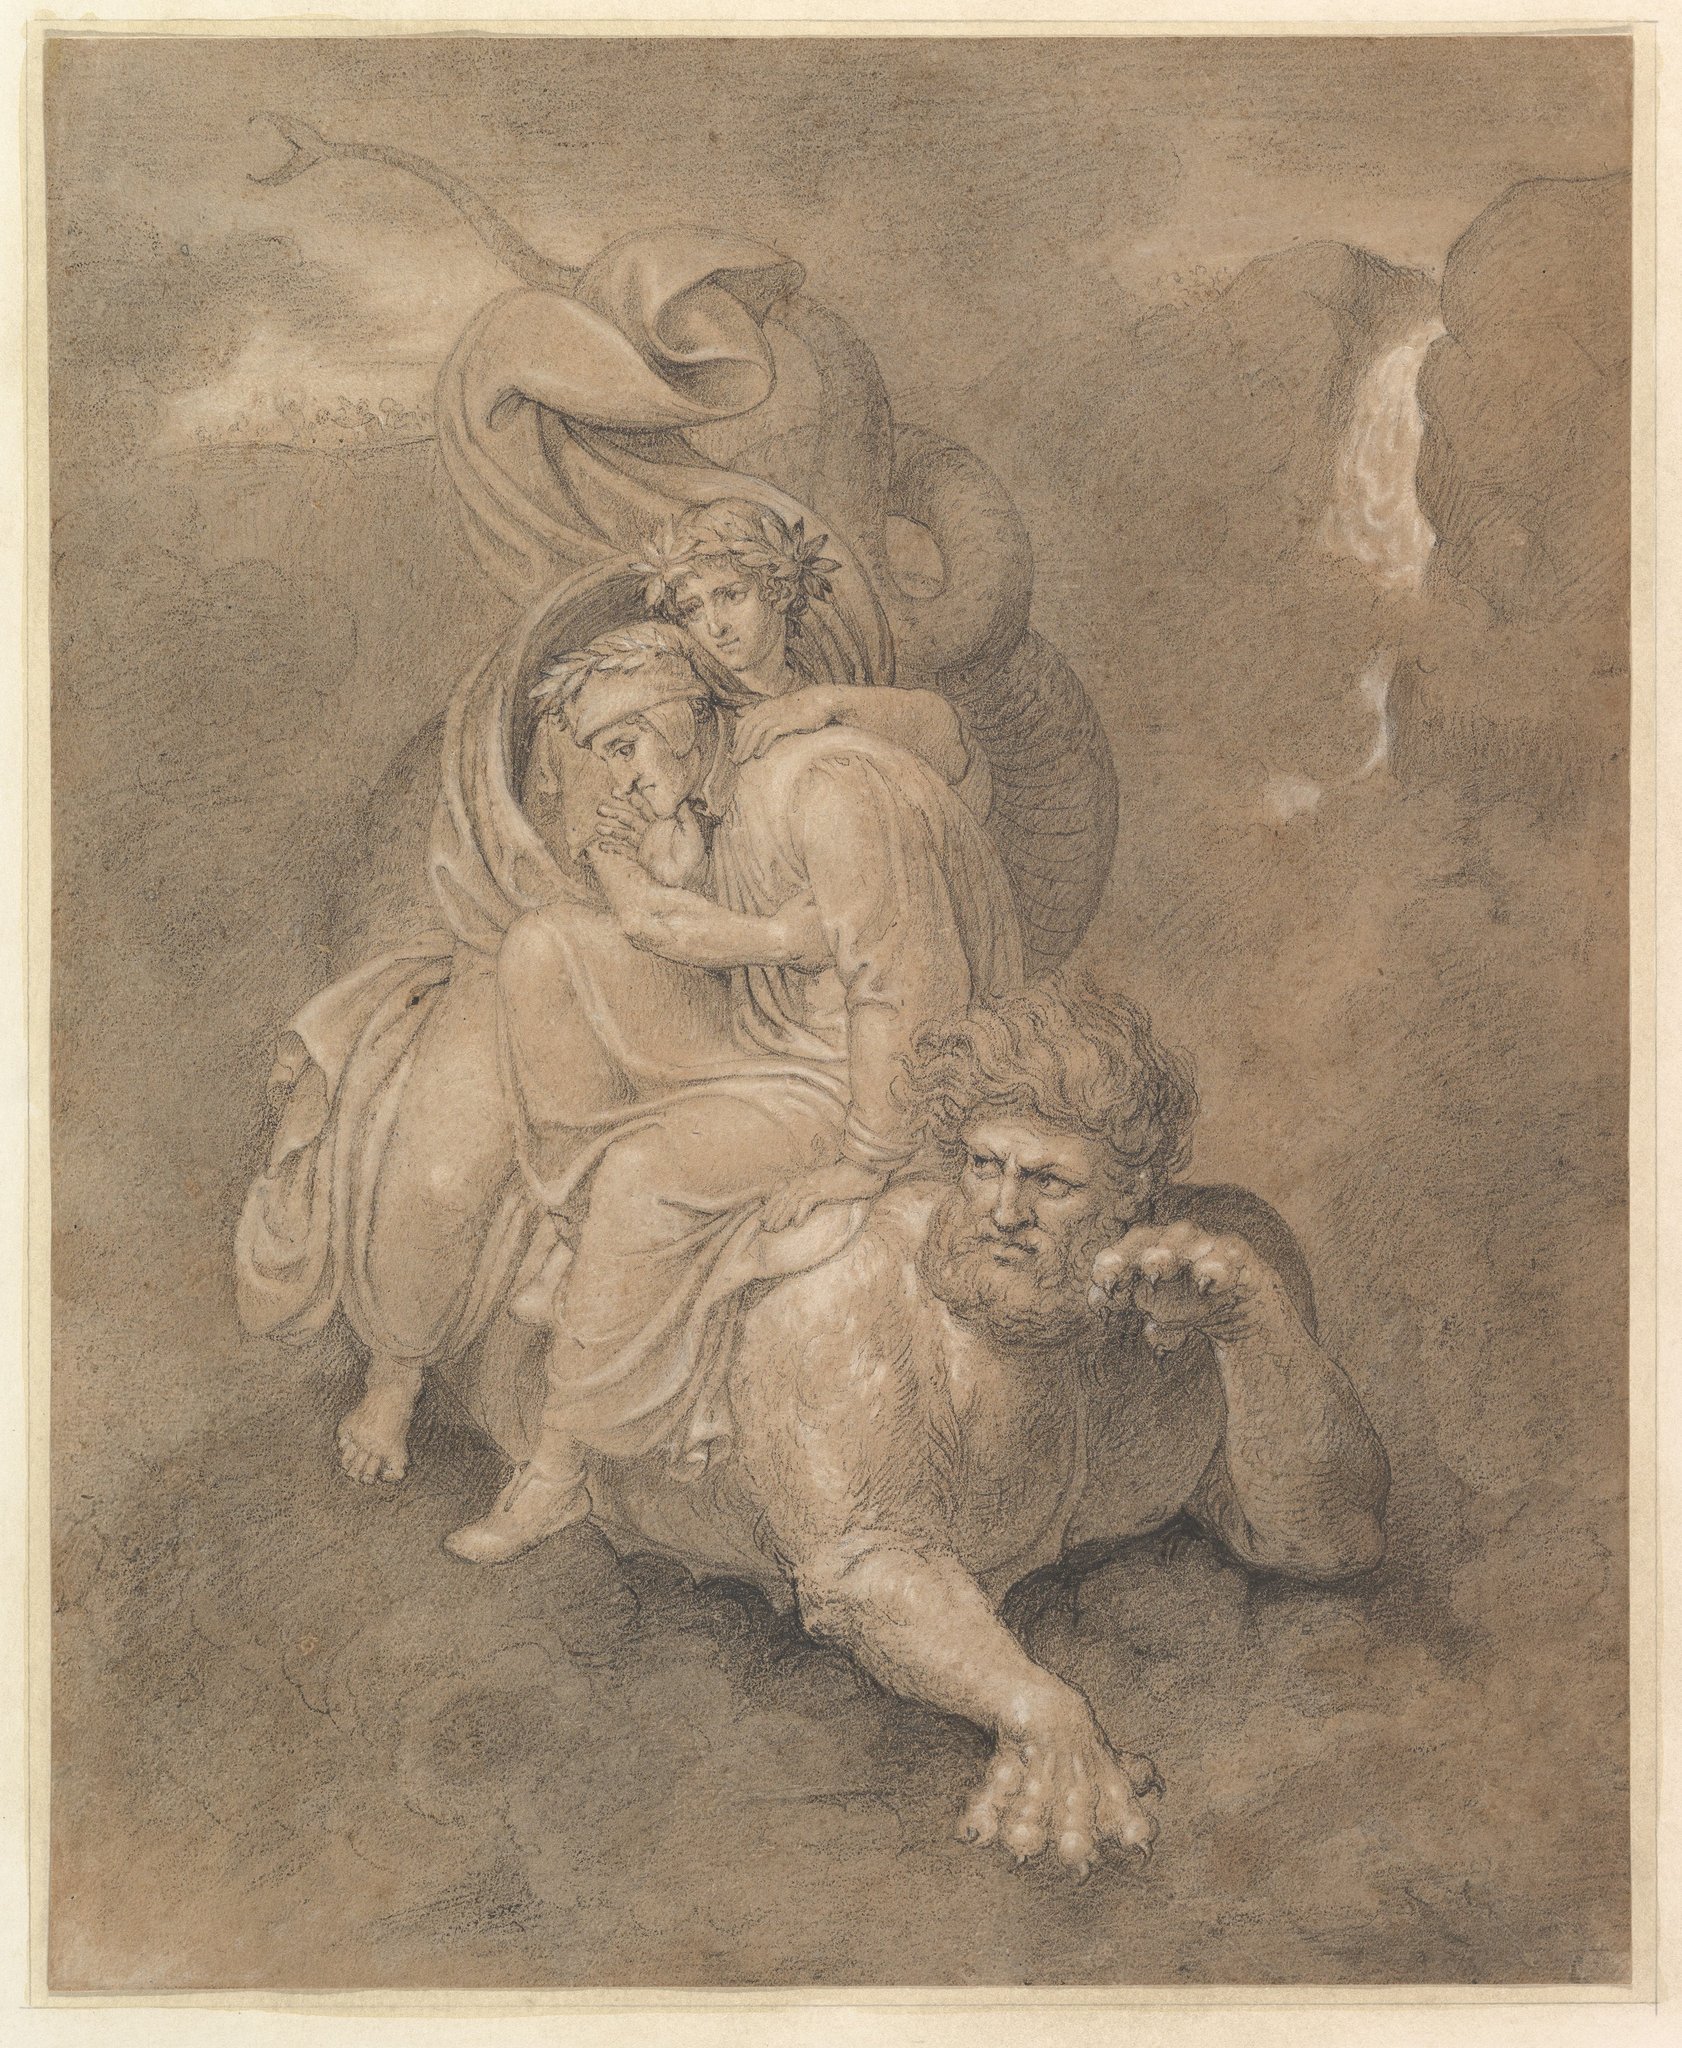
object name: drawing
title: Dante and Virgil on the back of Geryon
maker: bertel thorvaldsen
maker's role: artist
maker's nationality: danish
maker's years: 1770-1844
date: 1801-1833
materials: chalk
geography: denmark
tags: men,mythical creatures